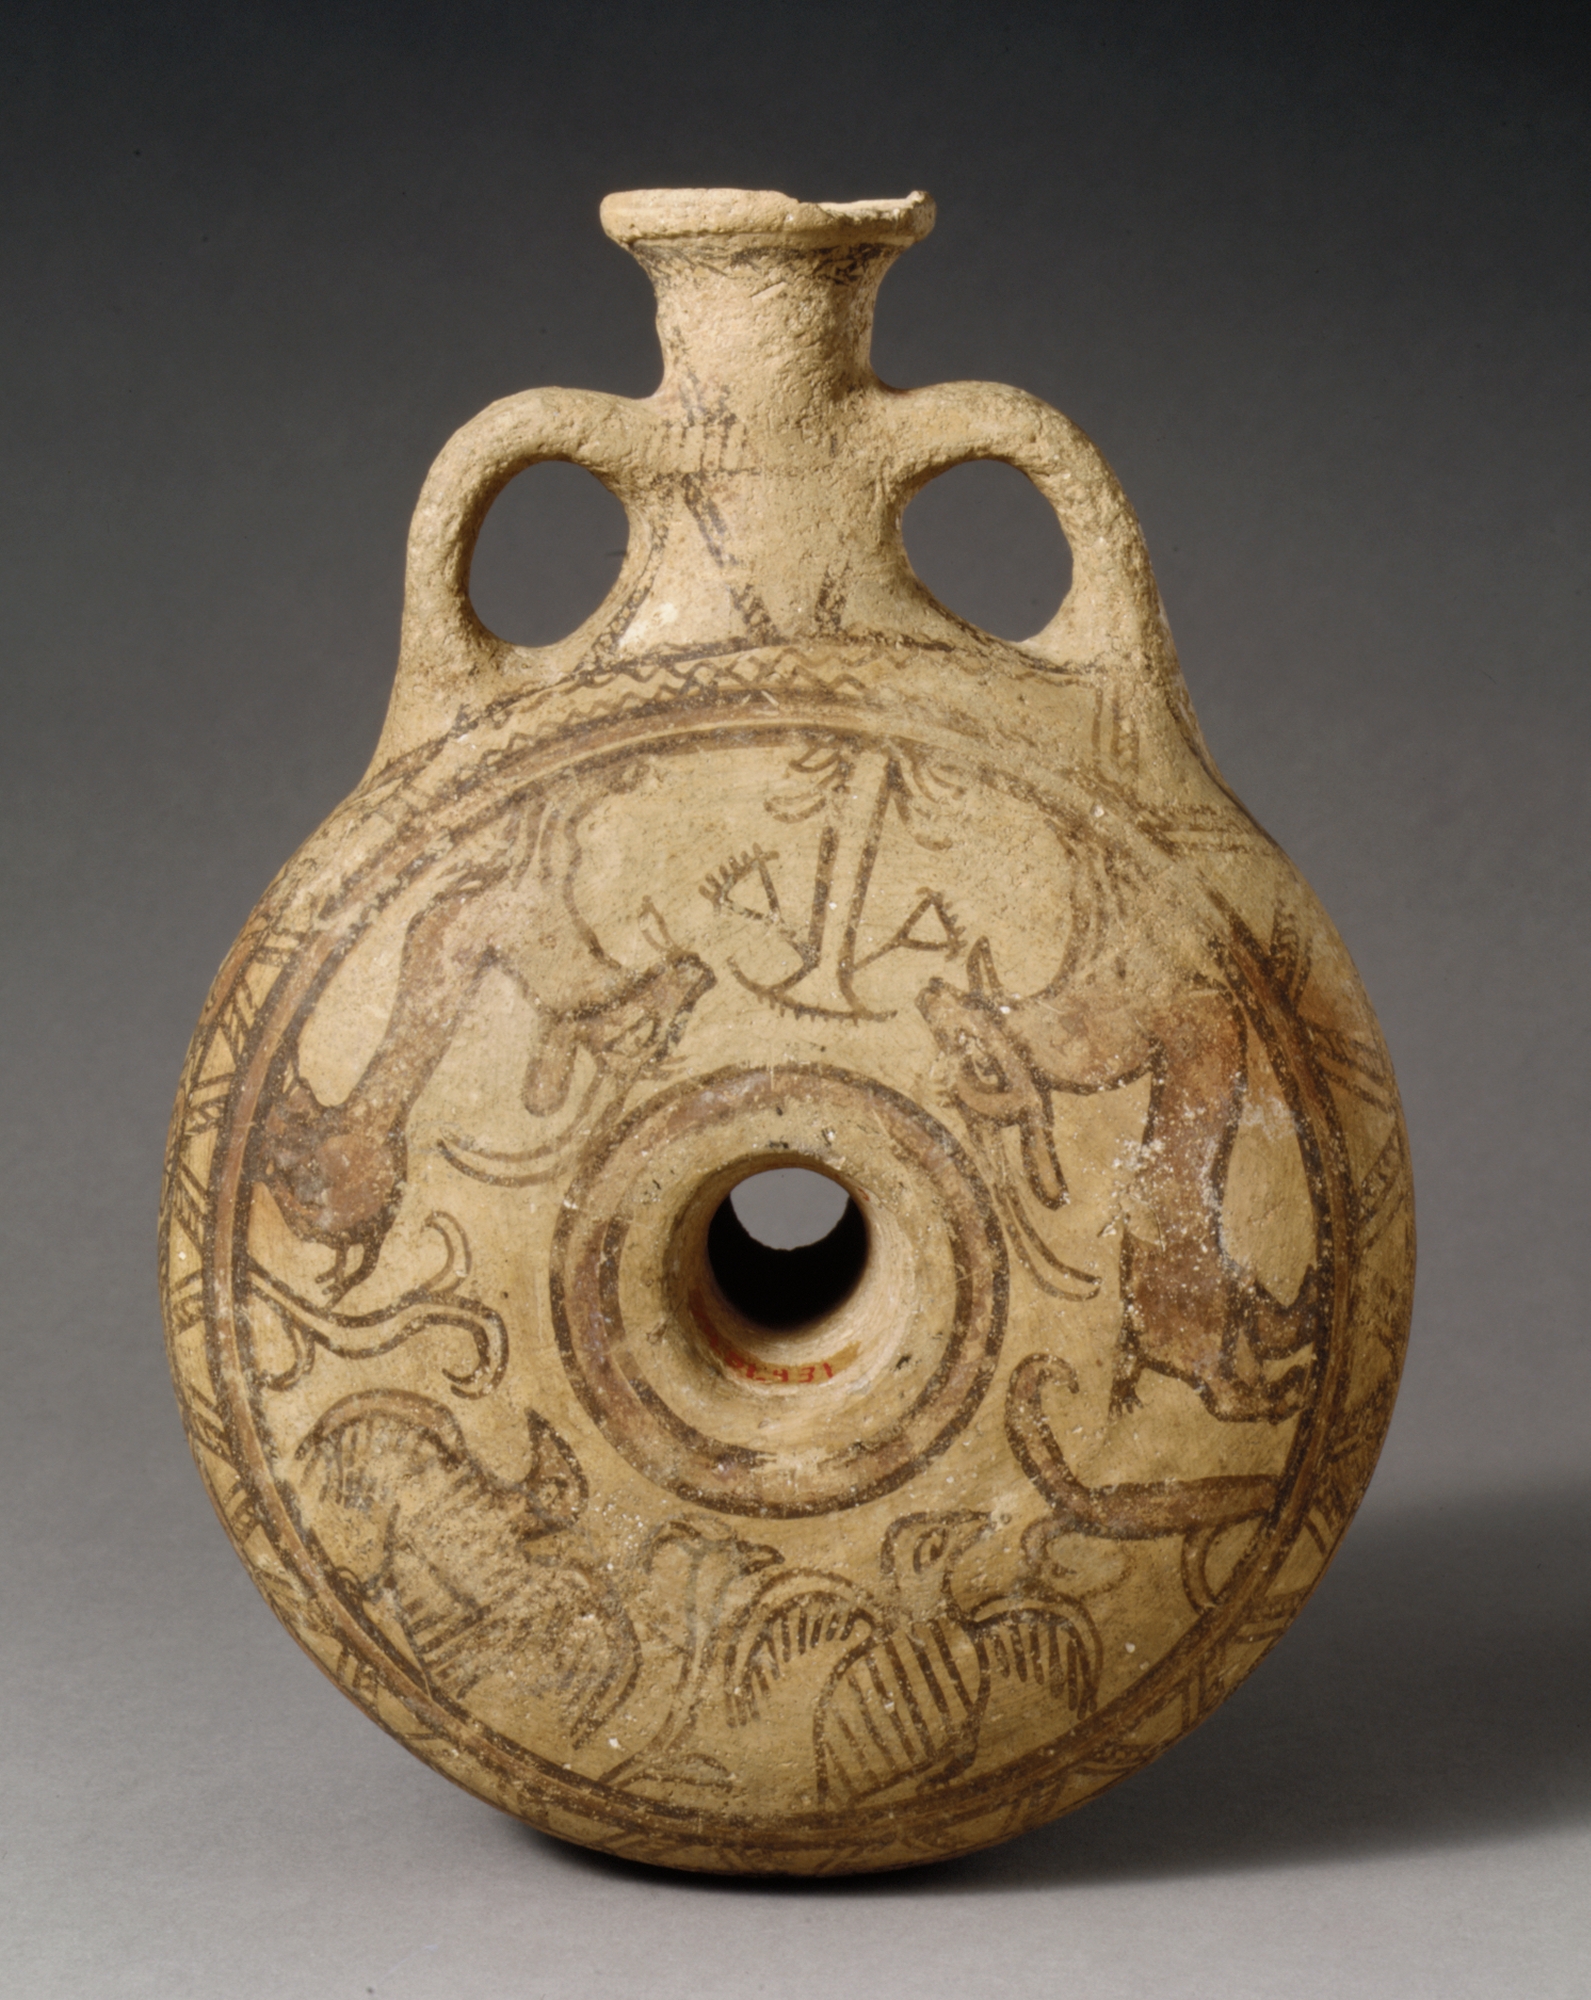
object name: flask, lentoid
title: Terracotta lentoid flask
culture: levantine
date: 1100-1001 BCE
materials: terracotta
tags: birds,goats